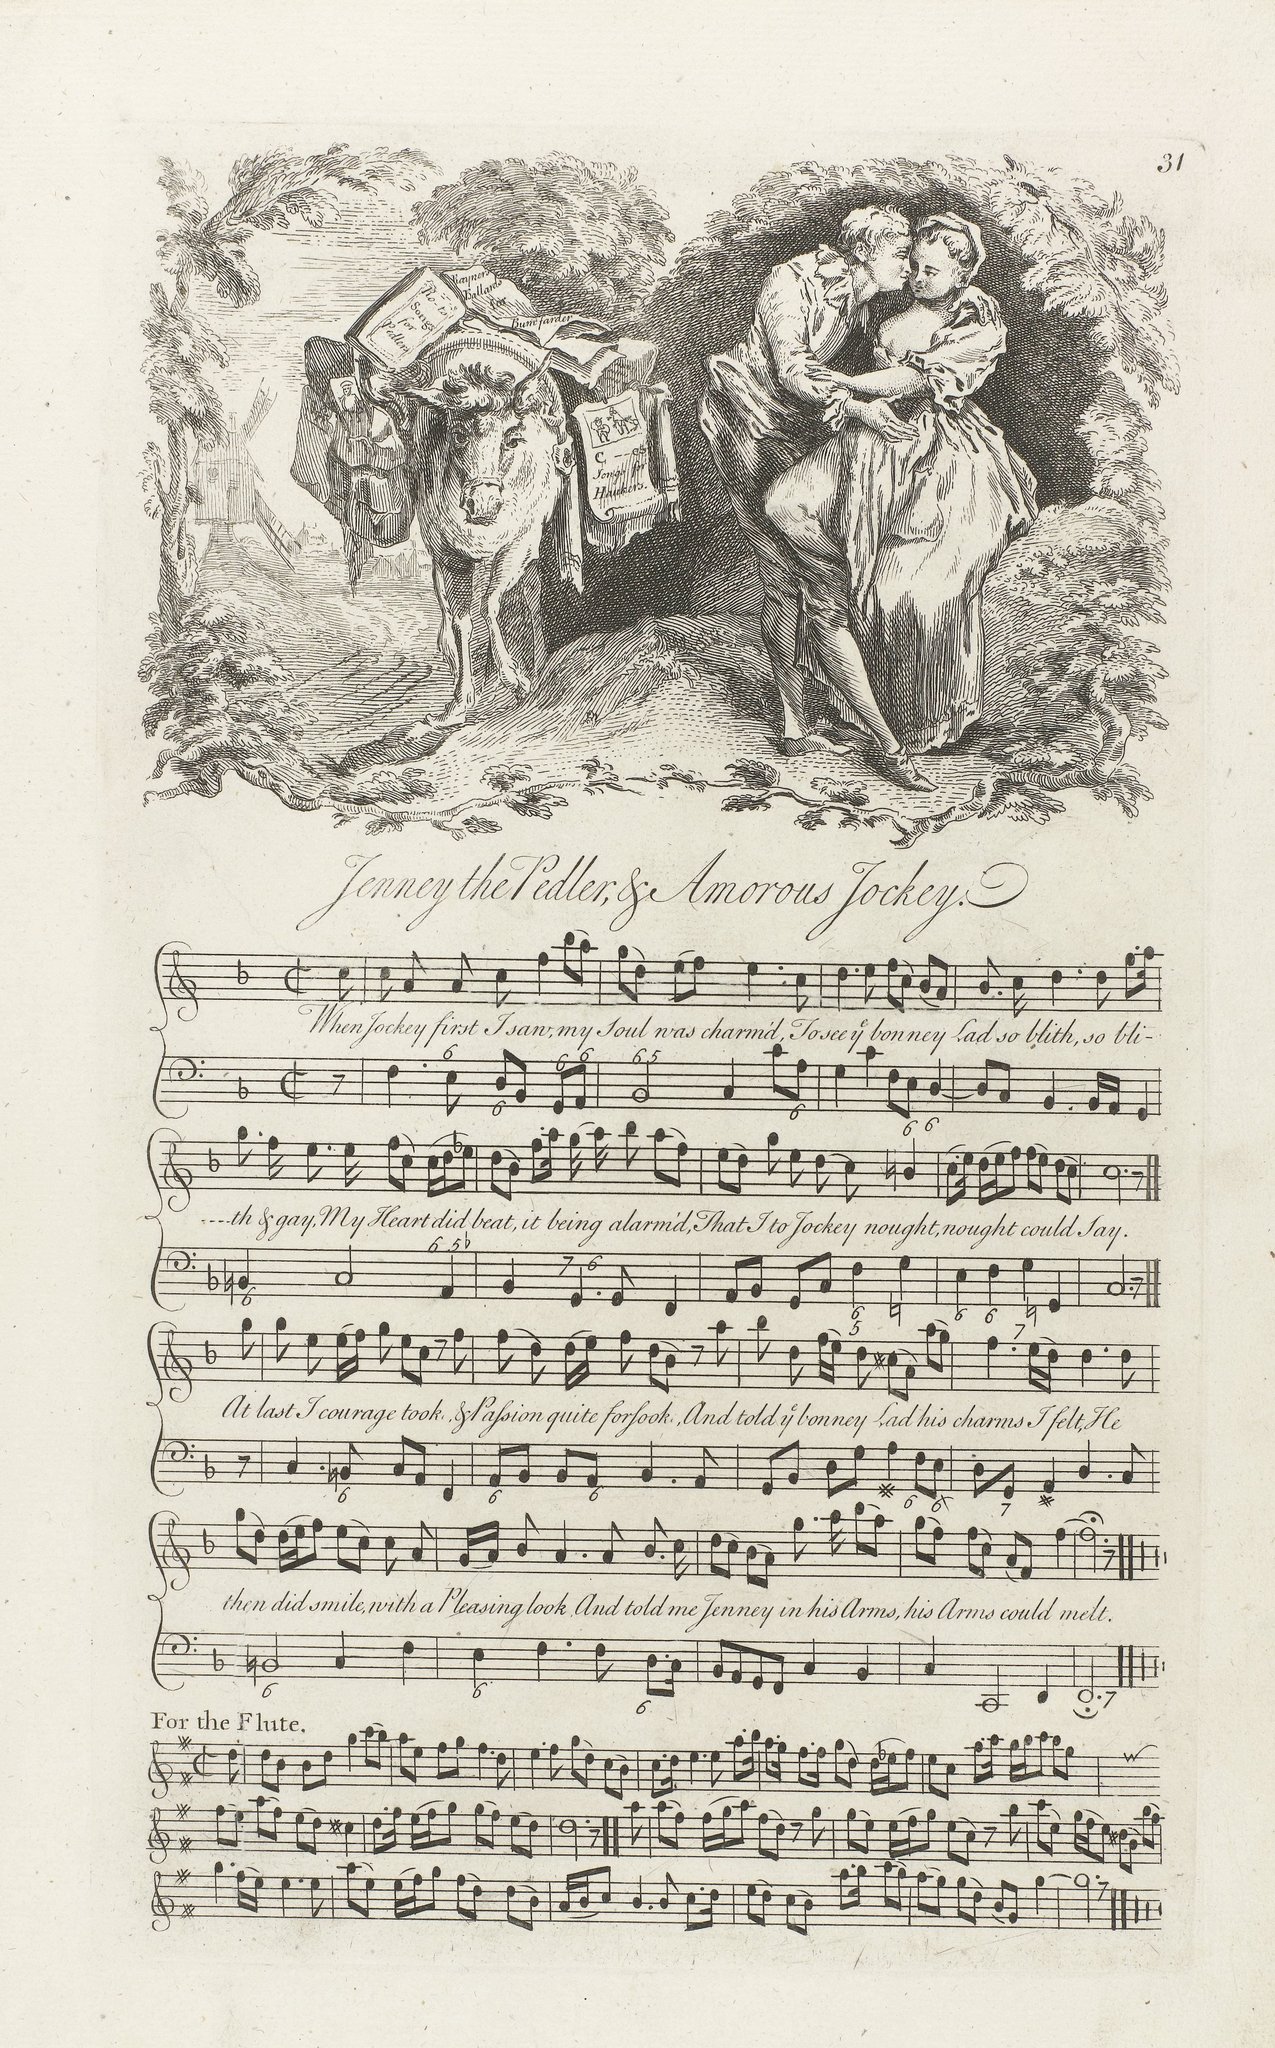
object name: print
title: Jenney the Pedler & Amorous Jockey (for Flute and Keybord Instrument)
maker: george bickham (ii)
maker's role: print maker, publisher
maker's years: 1706-1771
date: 1737-1740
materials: paper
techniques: engraving, etching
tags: print, e.g.: engraving, etching, lithograph, street-trader, mule, couple of lovers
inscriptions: collector's mark: Lugt 4780, collector's mark: Lugt 2228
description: Bladmuziek voor een liefdeslied voor zangstem, basso continuo en fluit. Er boven als illustratie rechts een liefkozend paar en links een ezel beladen met muziekboeken en losse bladen.